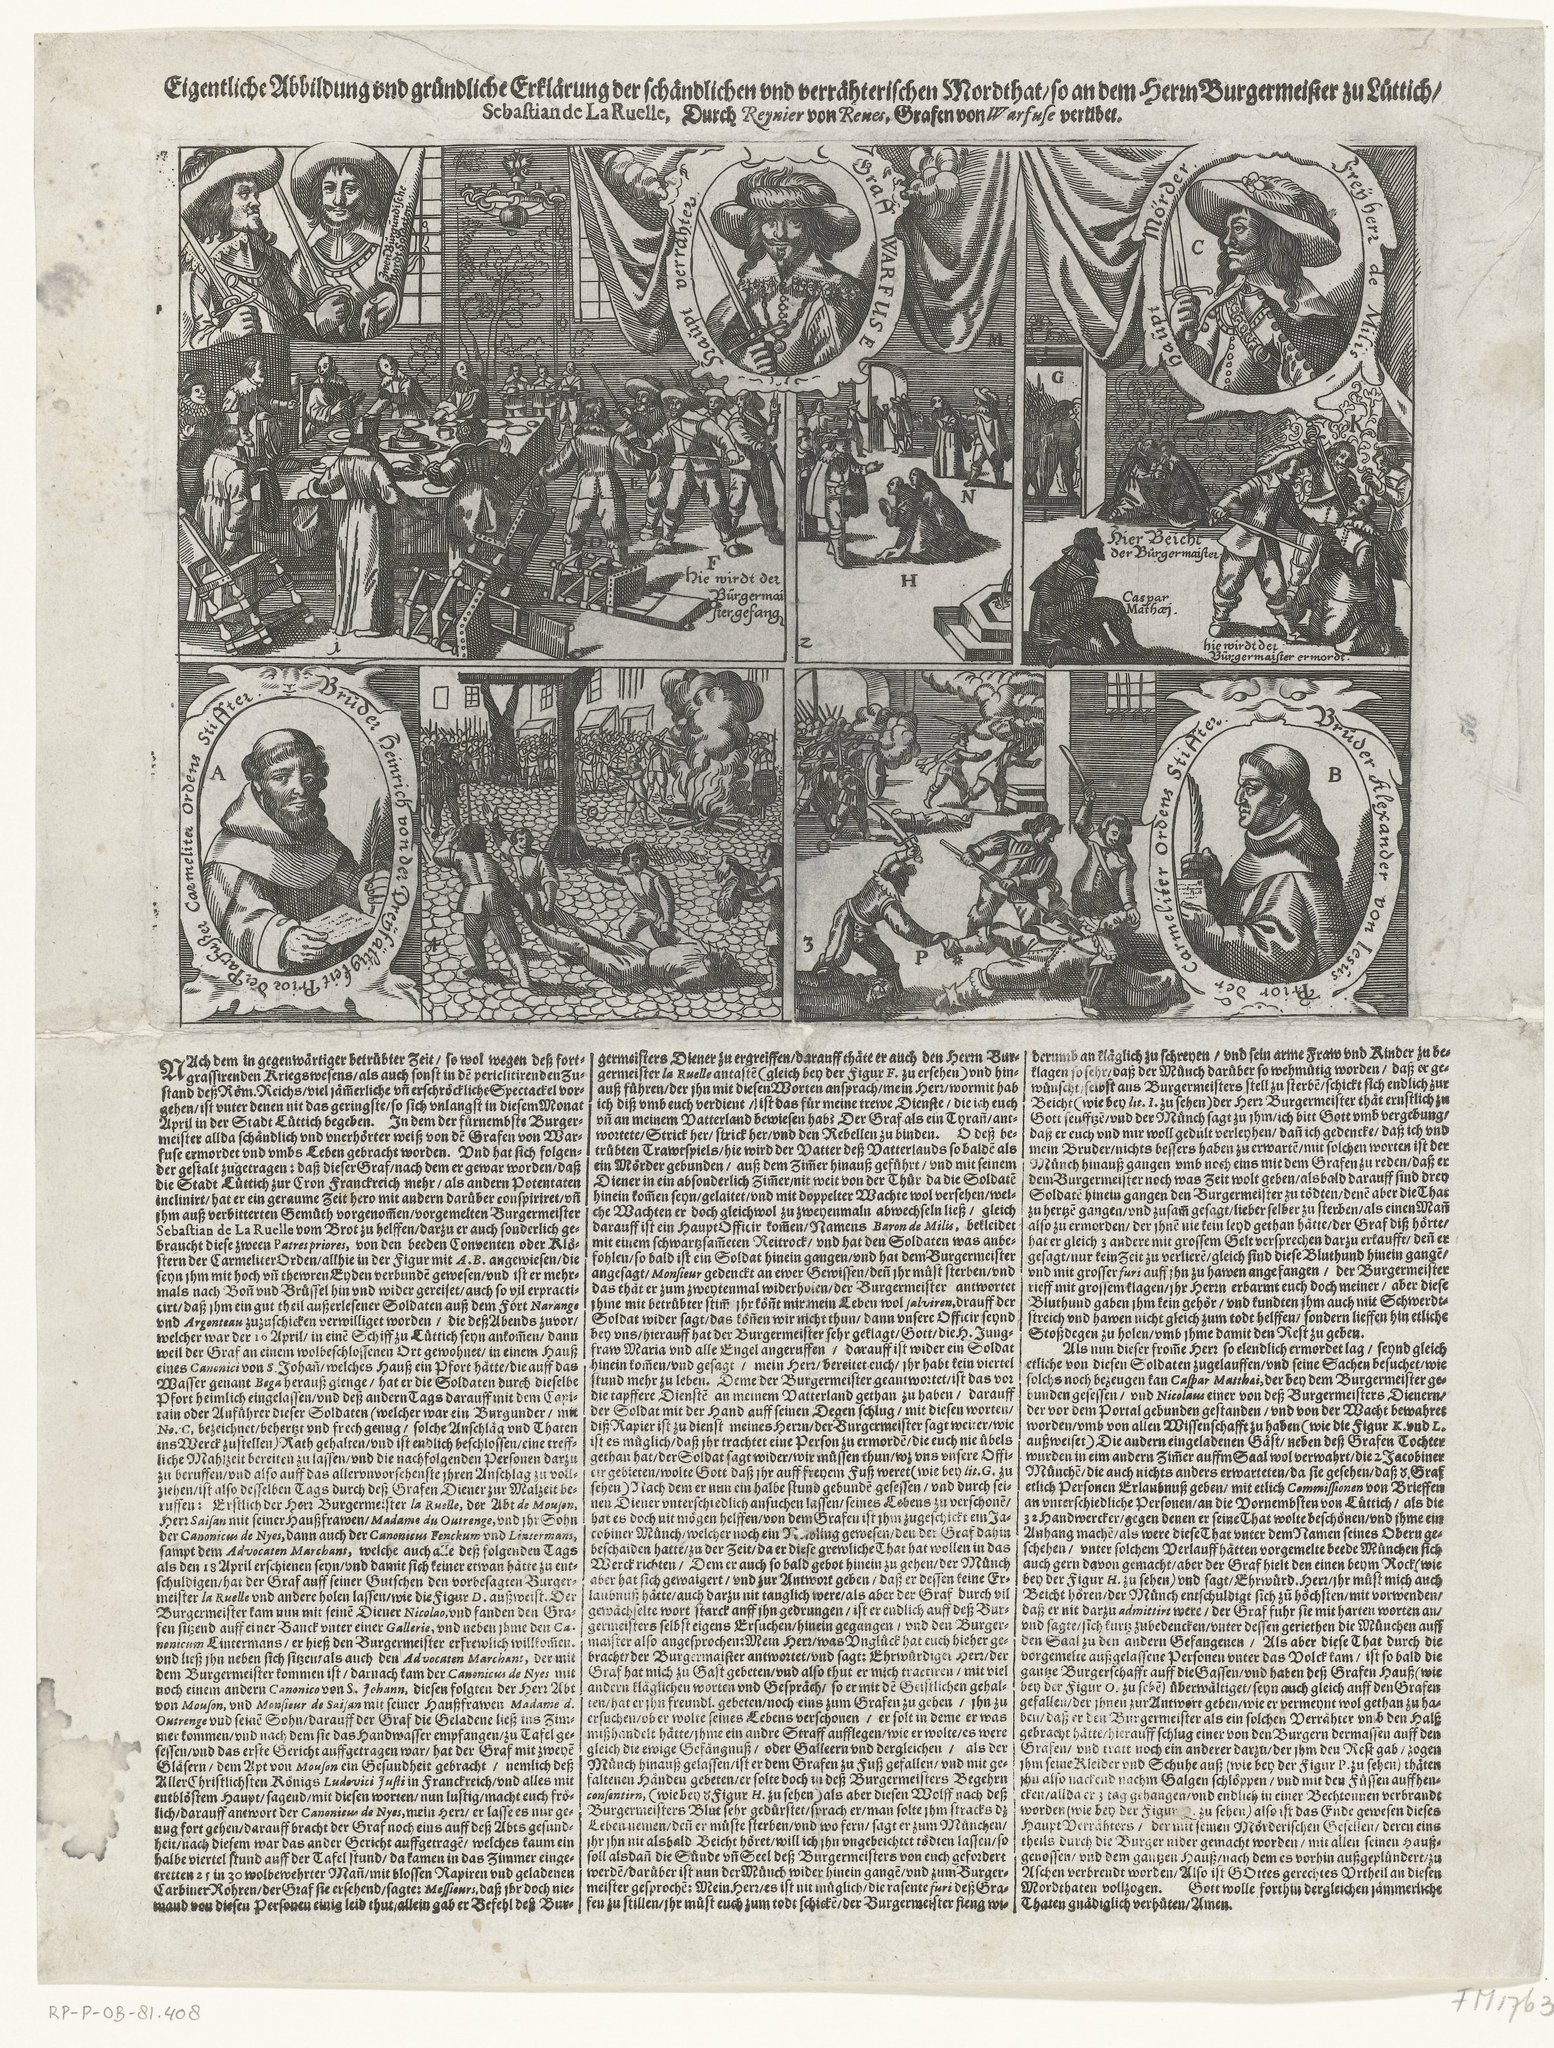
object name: print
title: Moord op Sebastiaen de la Ruelle, burgemeester van Luik, 1637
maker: Anonymous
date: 1637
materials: paper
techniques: etching, letterpress printing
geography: germany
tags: liège, politician, lynching, attempt, political murder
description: De moord gepleegd op Sebastiaen de la Ruelle, burgemeester van Luik, door Reinier van Renes, graaf de Warfusé, die de stad van Frankrijk onder Spaans bestuur wilde brengen, 16 april 1637. De moordenaar werd door burgers aangehouden en vermoord en zijn lichaam daarna naar de galg gesleept. Blad met de gebeurtenissen in 5 voorstellingen met portretten van de hoofdrolspelers. Onder de voorstelling een beschrijving van de gebeurtenissen in 3 kolommen in het Duits.